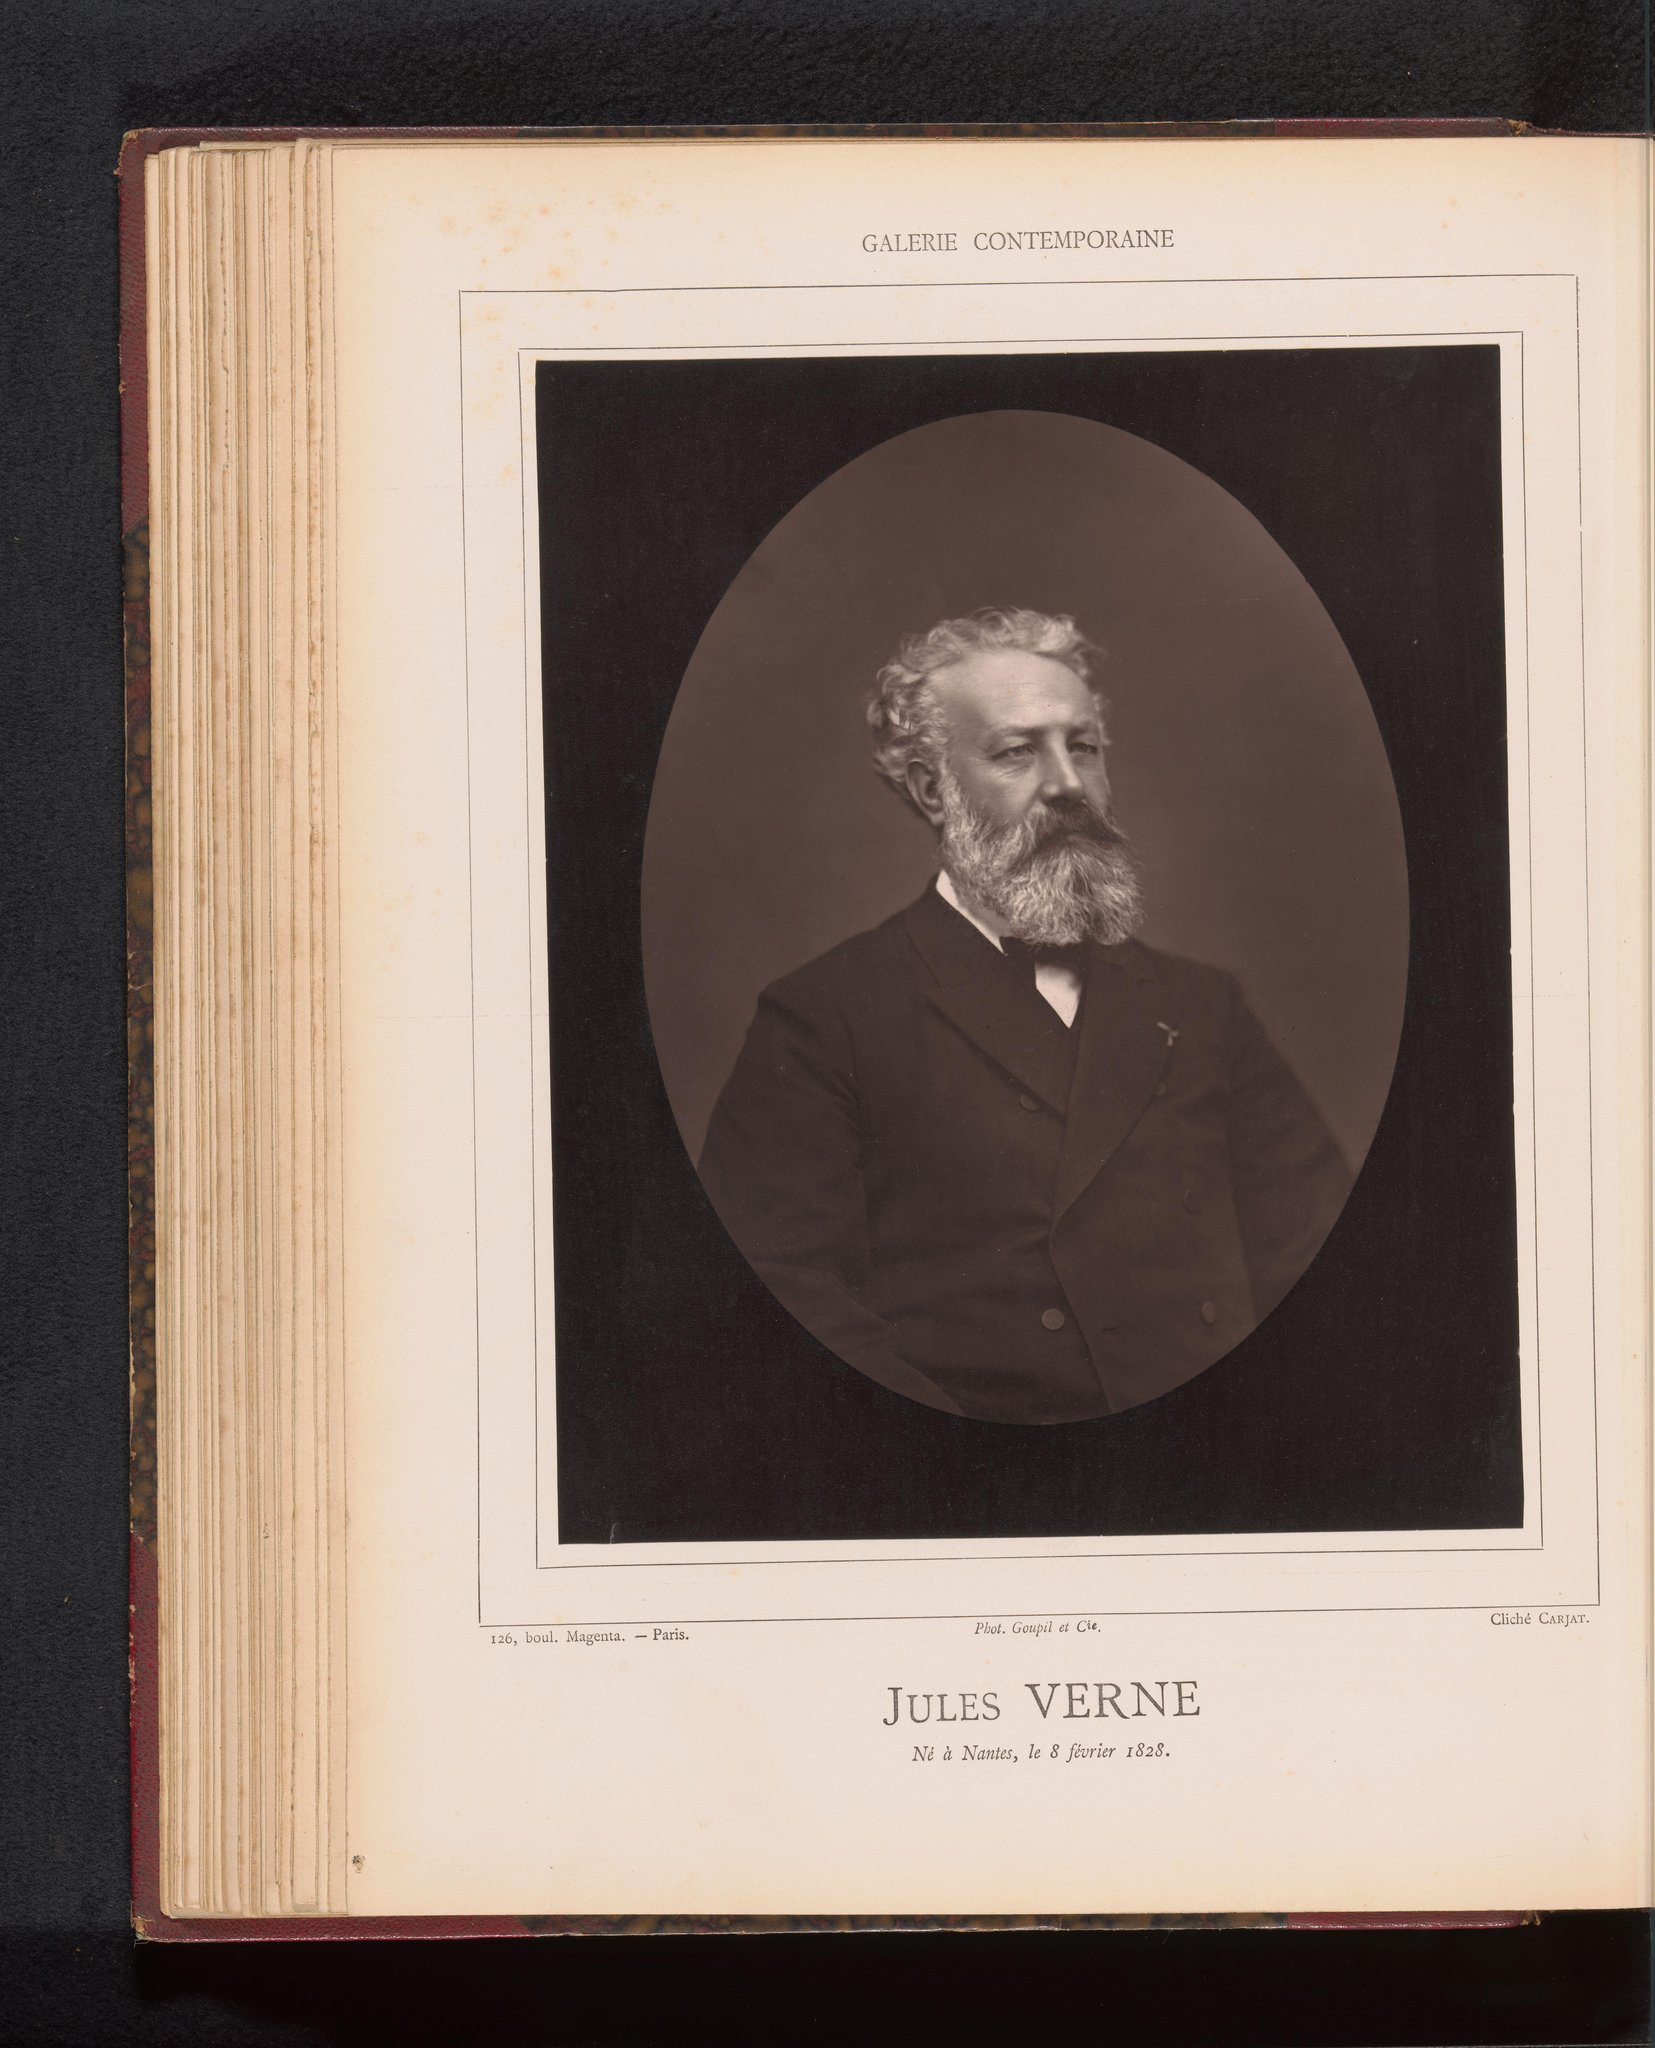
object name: page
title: Portret van Jules Verne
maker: étienne carjat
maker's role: draughtsman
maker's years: 1828-1906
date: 1873-1878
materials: paper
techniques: woodburytype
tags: adult man, historical persons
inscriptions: inscription: ‘Galerie Contemporaine/ 126, boulevard Magenta. - Paris./ Né à Nantes, le 8 février 1828.’